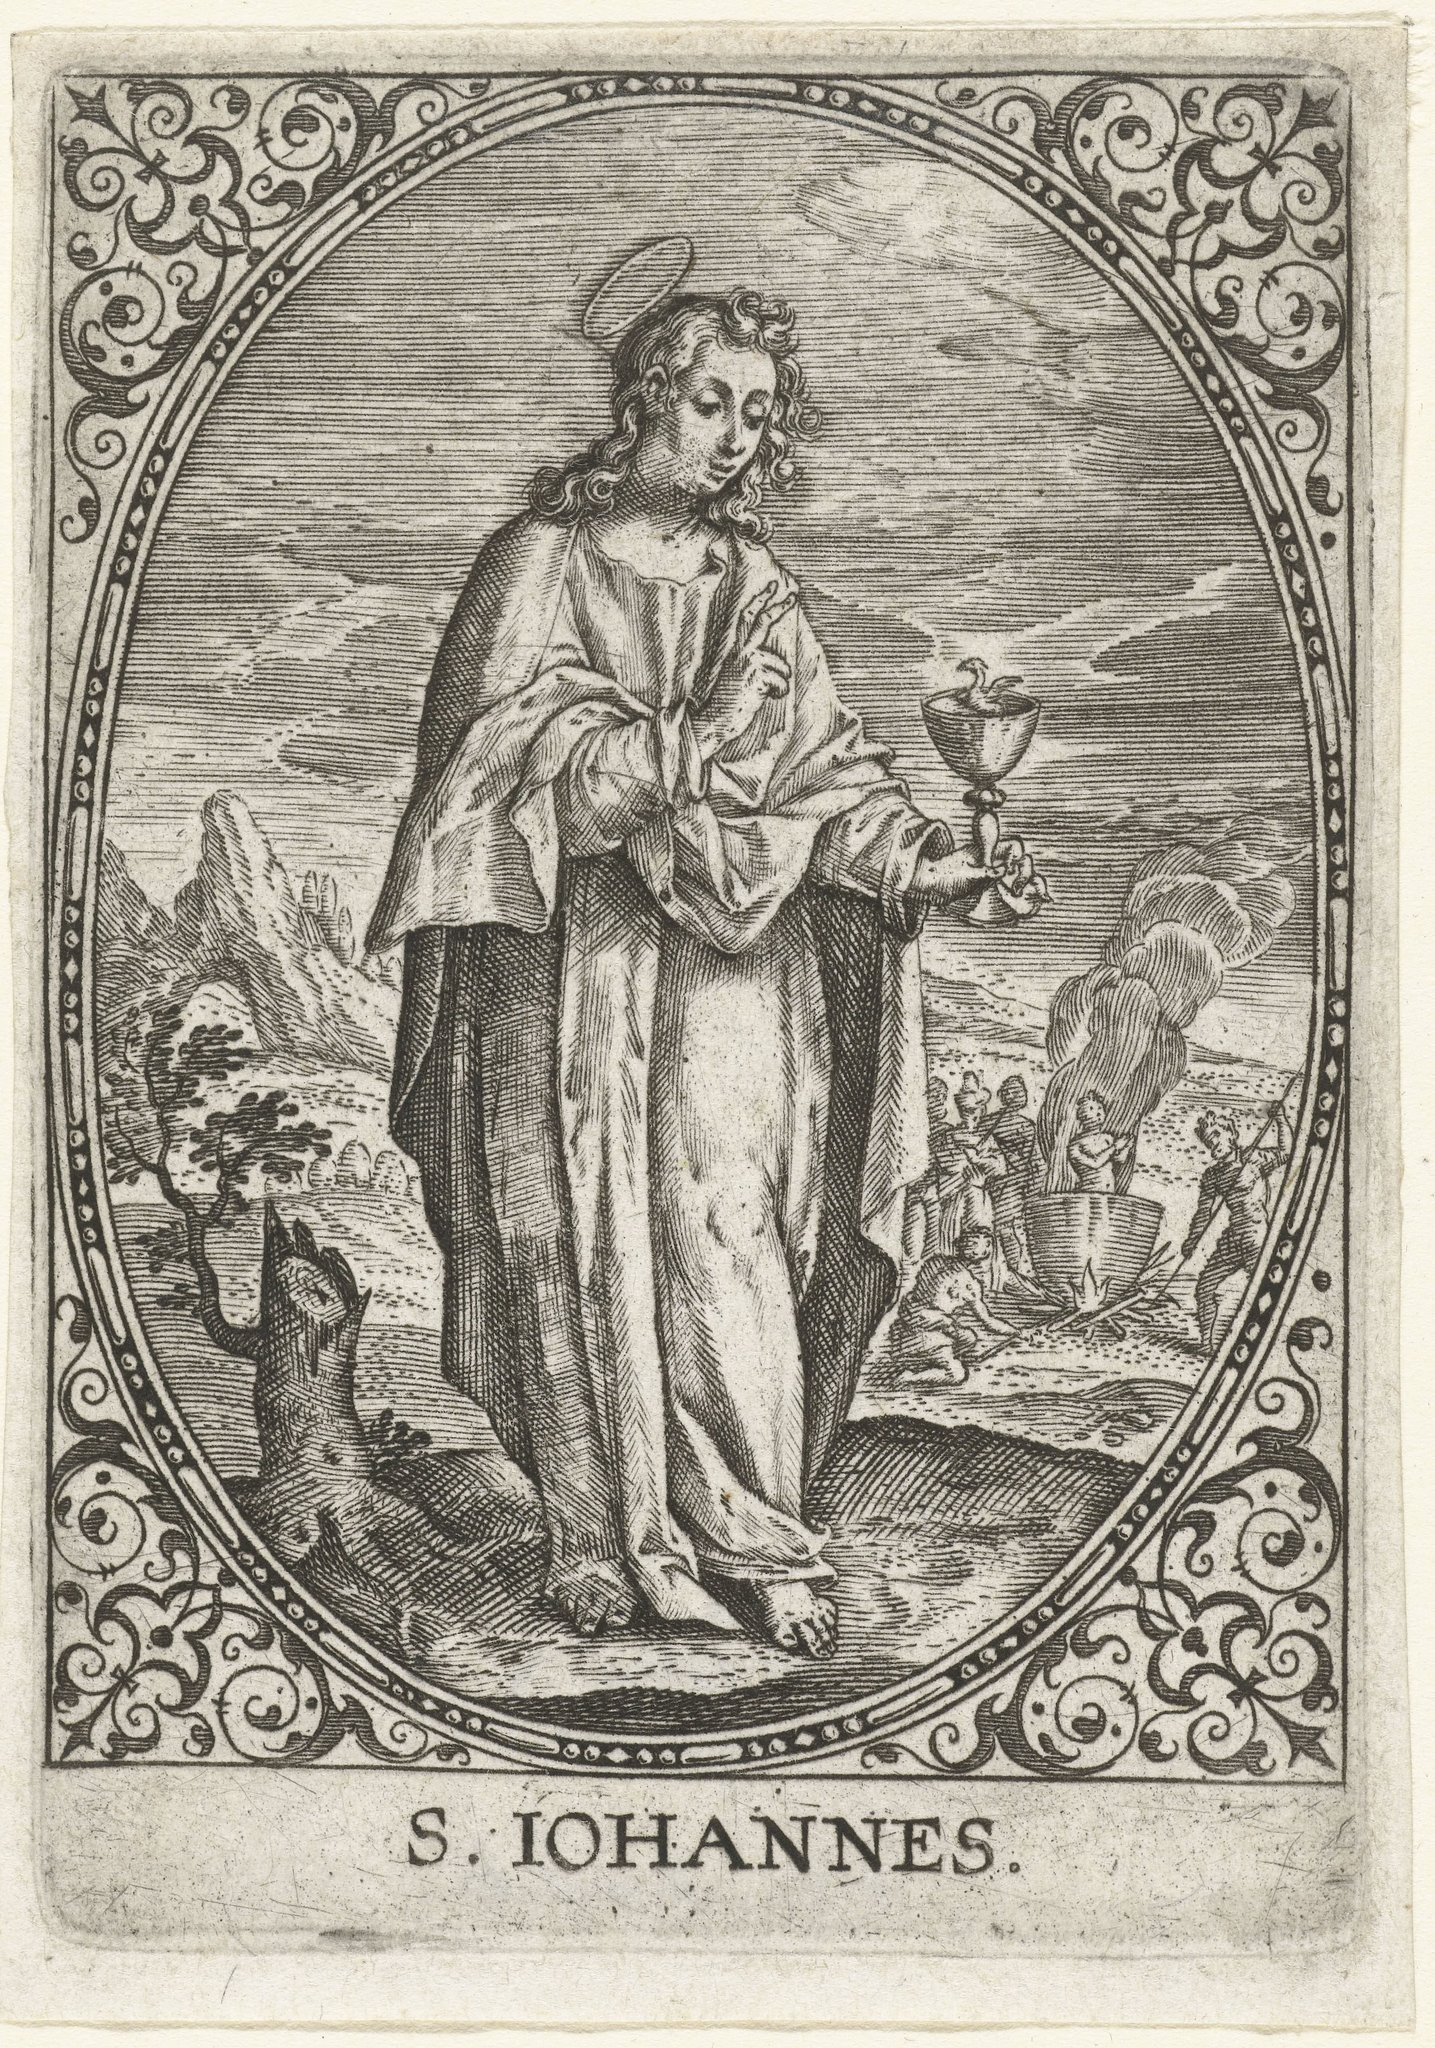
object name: print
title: S. Iohannes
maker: adriaen collaert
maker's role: draughtsman, print maker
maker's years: 1560-1618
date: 1570-1618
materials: paper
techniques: engraving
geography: antwerp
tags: the apostle john the evangelist; possible attributes: book, cauldron, chalice with snake, eagle, palm, scroll, the apostle john the evangelist; possible attributes: book, cauldron, chalice with snake, eagle, palm, scroll - martyrdom, suffering, misfortune, death of male saint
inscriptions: collector's mark: Lugt 2760, collector's mark: Lugt 2228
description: Johannes de Evangelist in een ovaal medaillon. Hij houdt de vergiftigde miskelk vast waaruit een slang kruipt en maakt een zegenend gebaar. Op de achtergrond zijn marteling, ondergedompeld in een ketel met kokende olie.